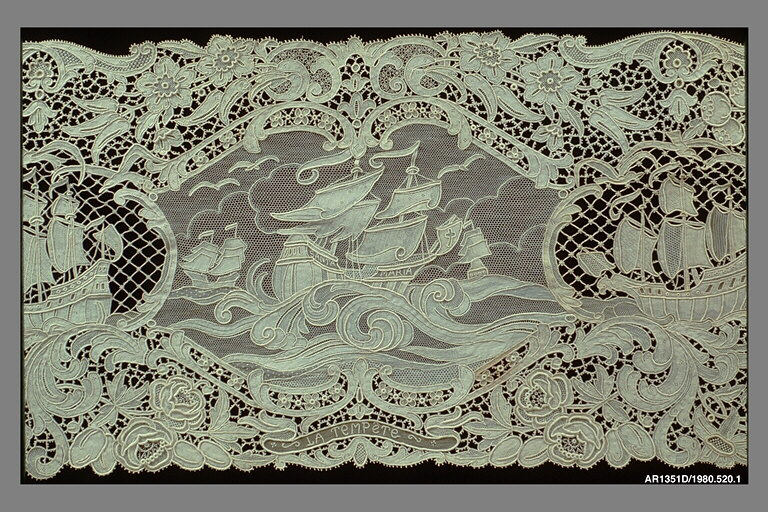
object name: runner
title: Runner (from a set of table linens)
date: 1867-1900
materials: linen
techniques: lace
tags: flowers,ships